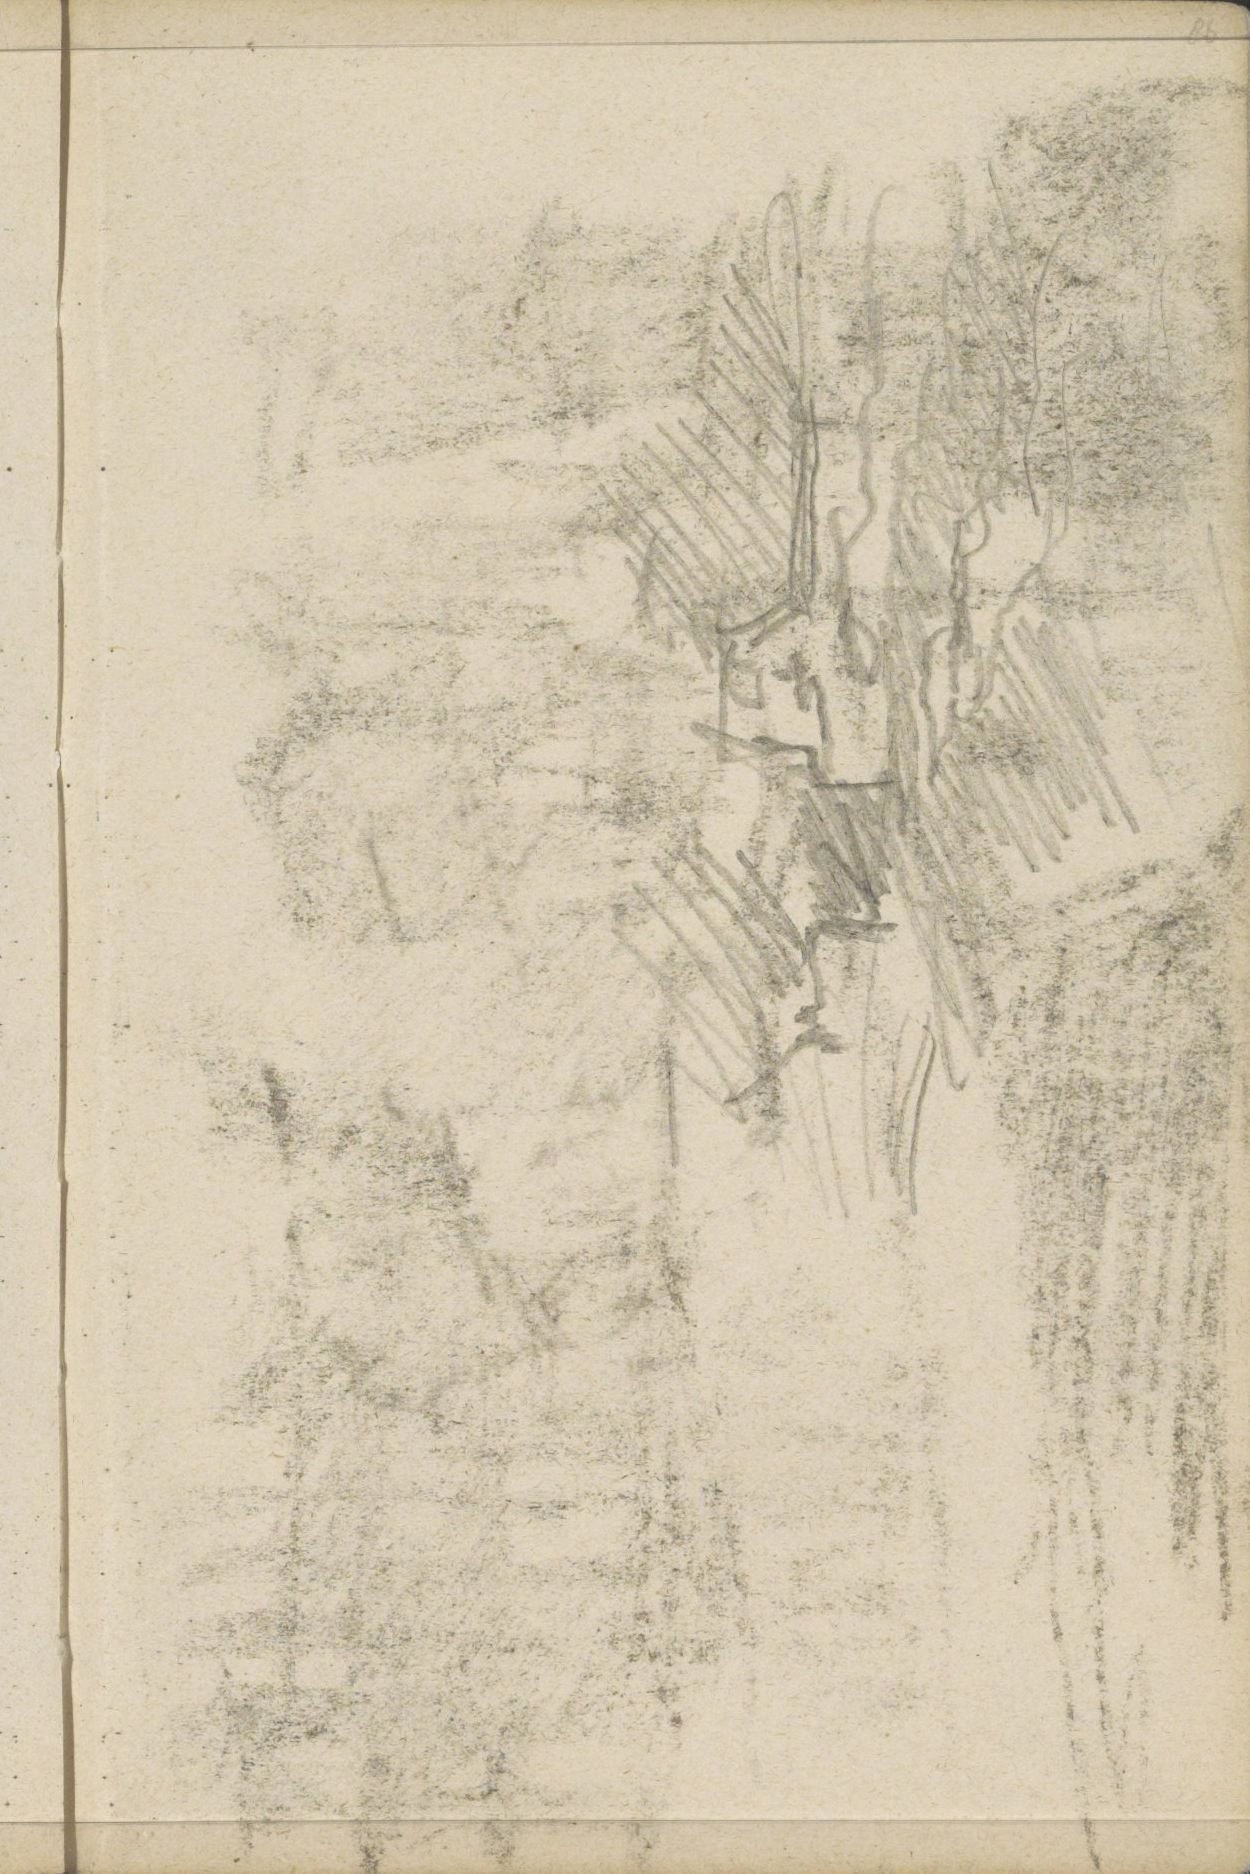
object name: sketchbook leaf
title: Studie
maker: george hendrik breitner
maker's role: draughtsman, painter, print maker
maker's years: 1857-1923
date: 1909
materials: paper, pencil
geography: amsterdam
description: Studie. Pagina 86 uit een schetsboek met 45 bladen vervaardigd in Amsterdam en Pittsburgh.